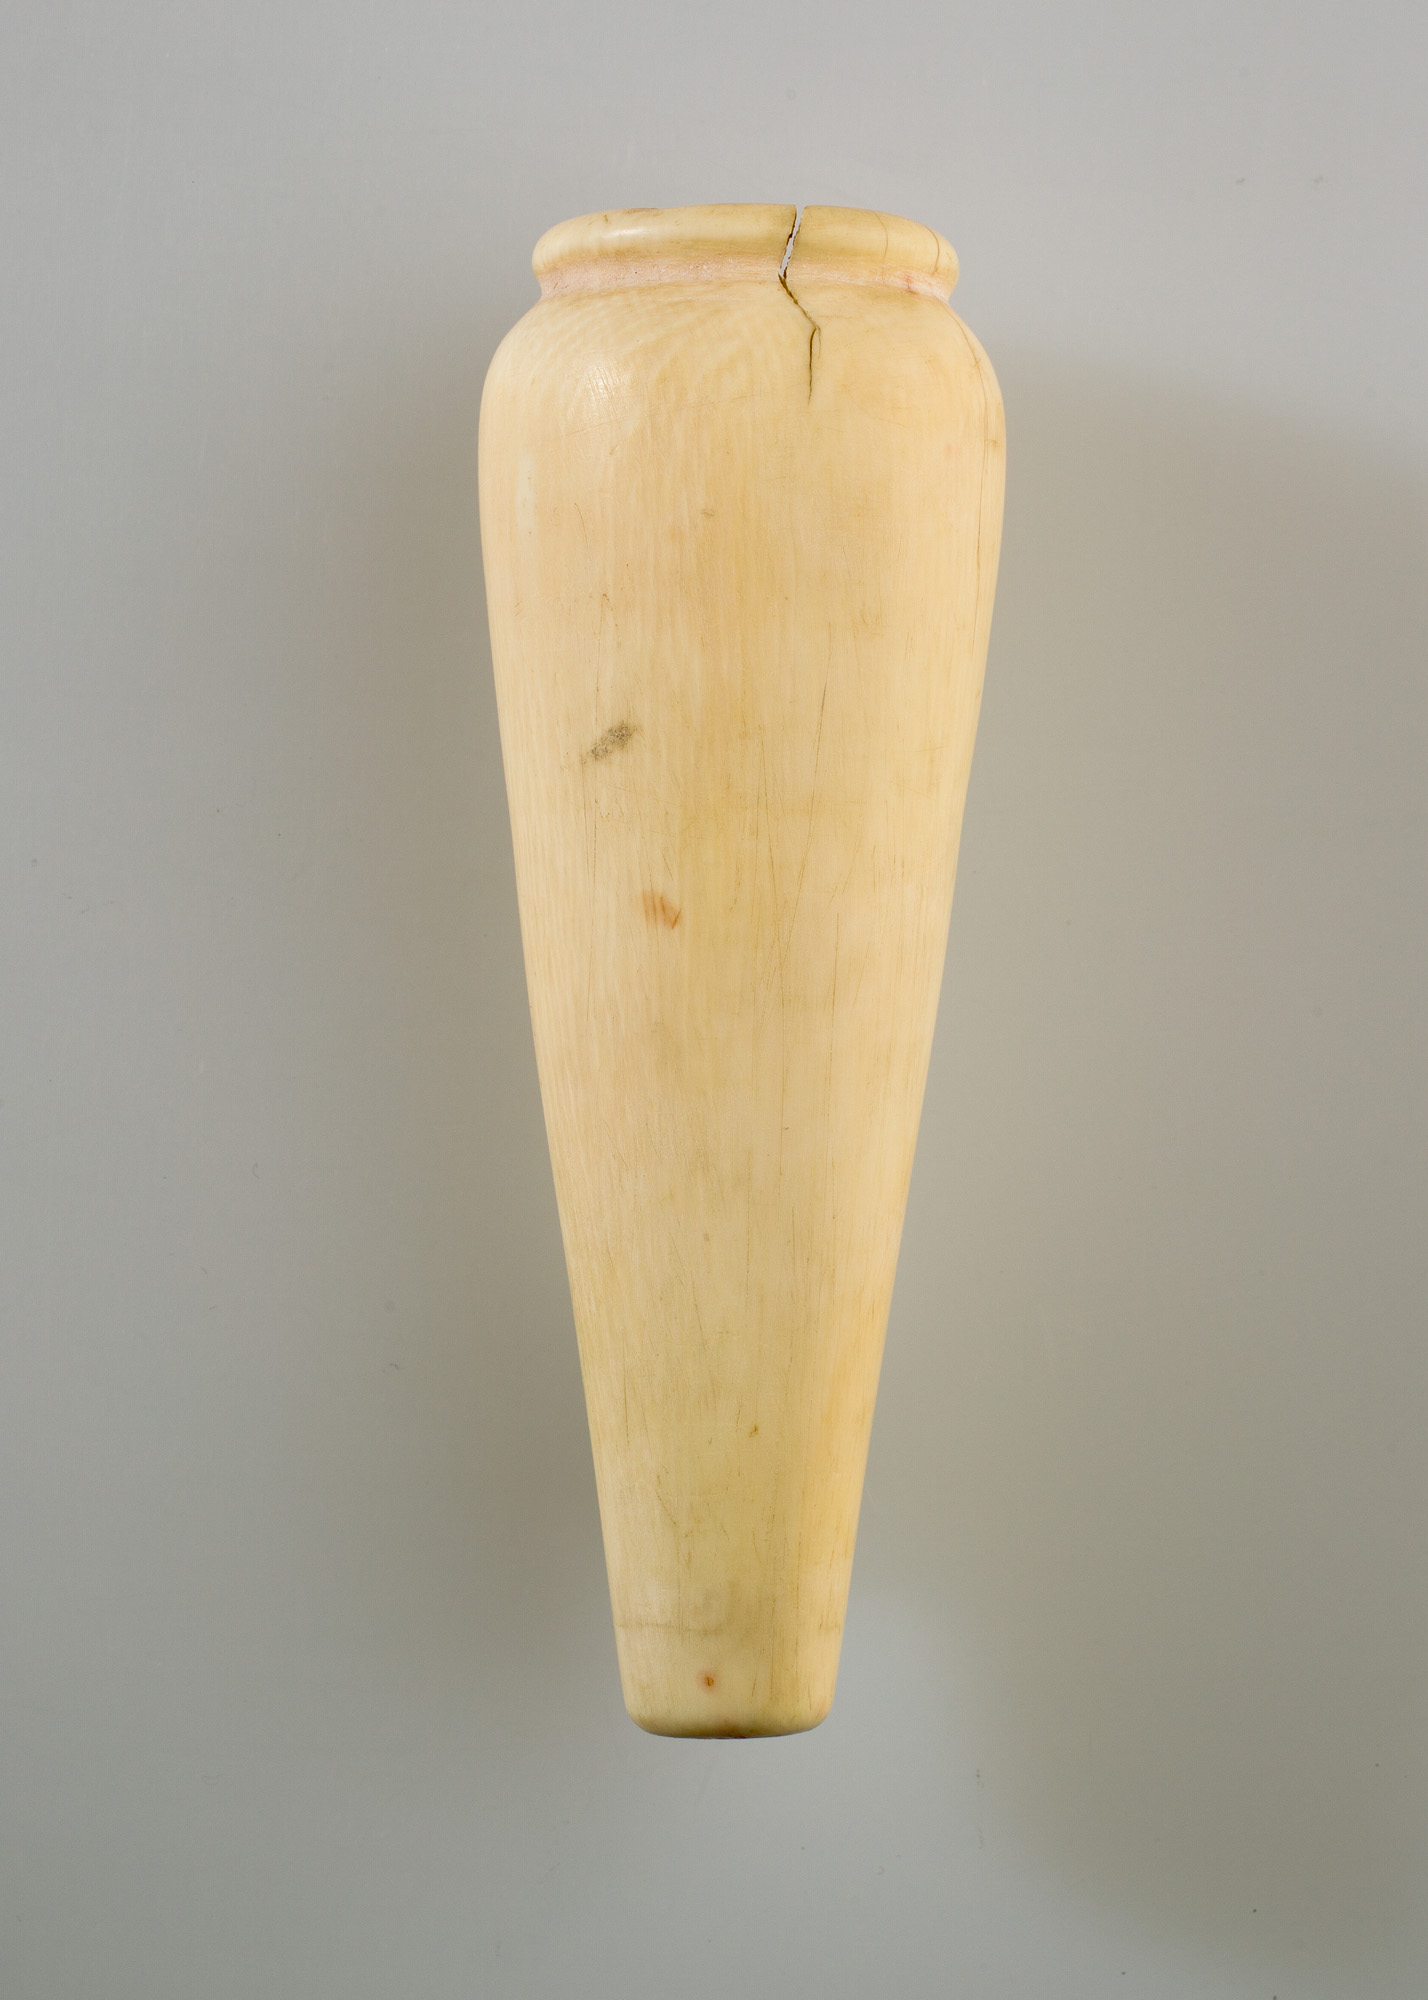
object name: model jar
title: Jar, model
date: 2960-2770 BCE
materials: ivory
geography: egypt